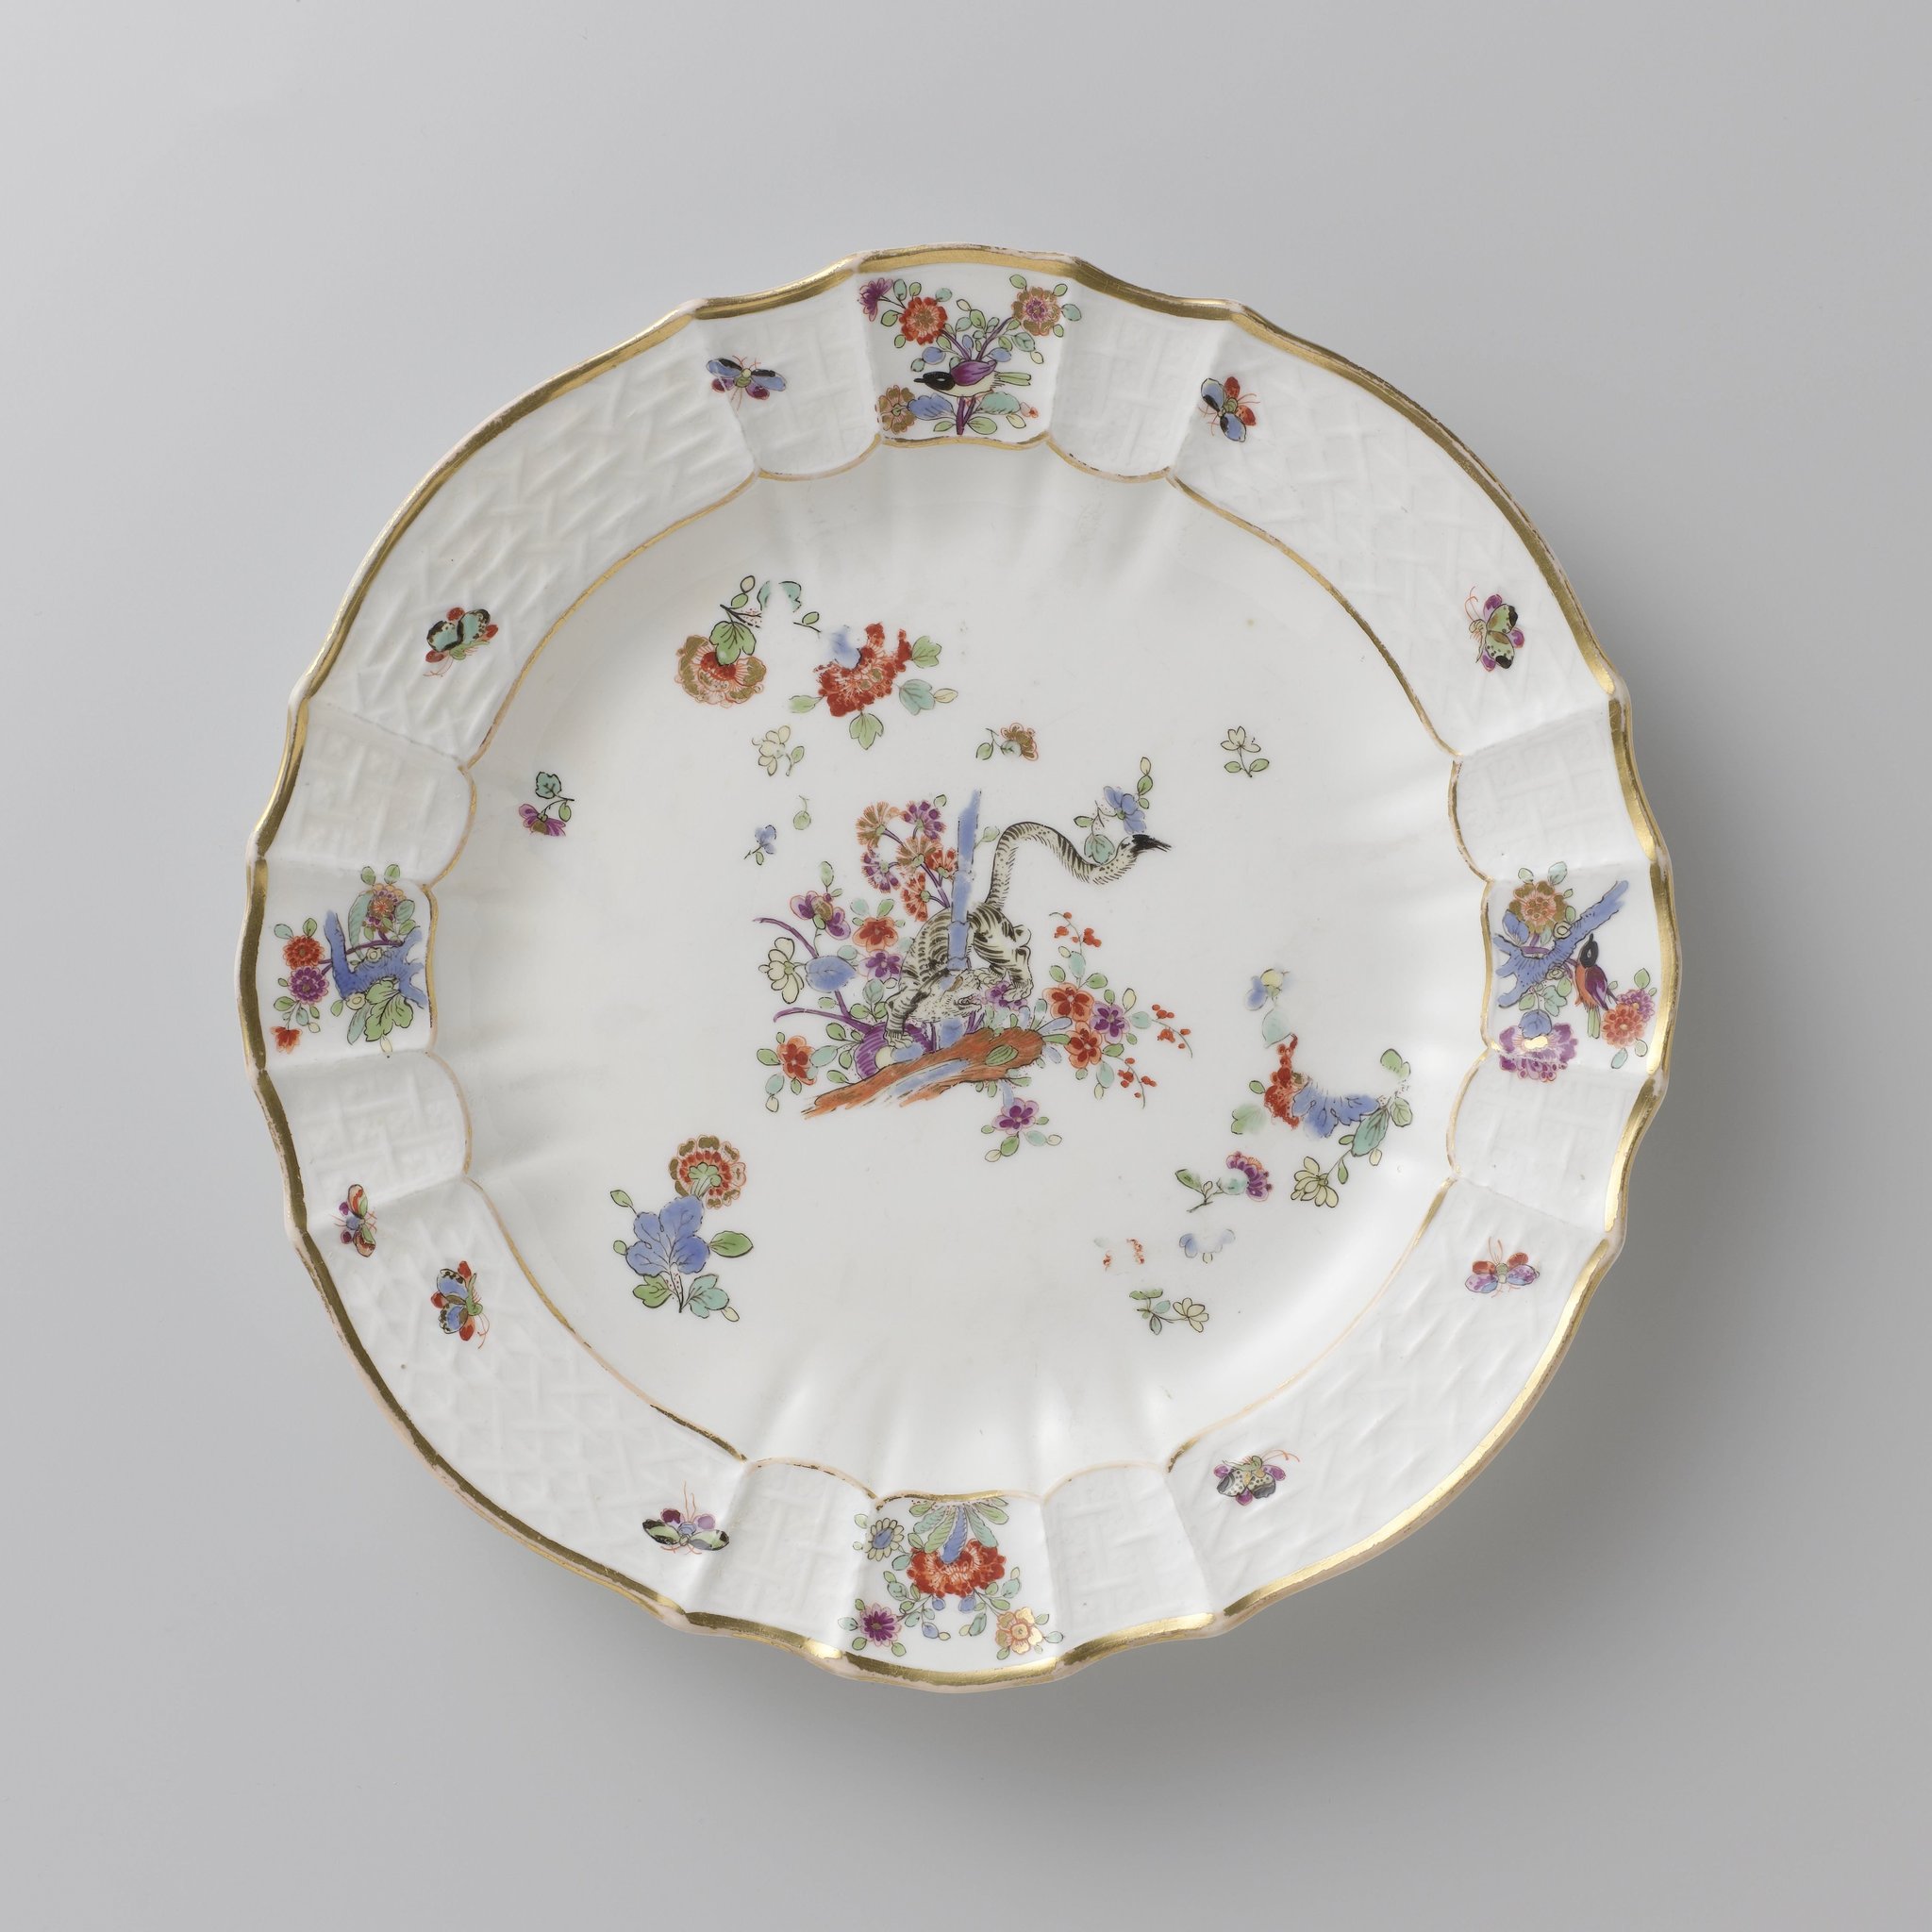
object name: eating drinking utensil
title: Rond bord, veelkleurig beschilderd met een Kakiemon-decor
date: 1740-1745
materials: porcelain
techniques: painted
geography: meissen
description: Rond bord van beschilderd porselein. Het bord is geribd en heeft een geschulpte rand. Het bord is beschilderd met een tijger die om een blauwe bamboestengel tussen bloemen is gedraaid, gestrooide Indianische Blumen, vlinders en takken waarop vogels. De rand is versierd met het 'Altbrandenstein'-patroon. Het bord is gemerkt.